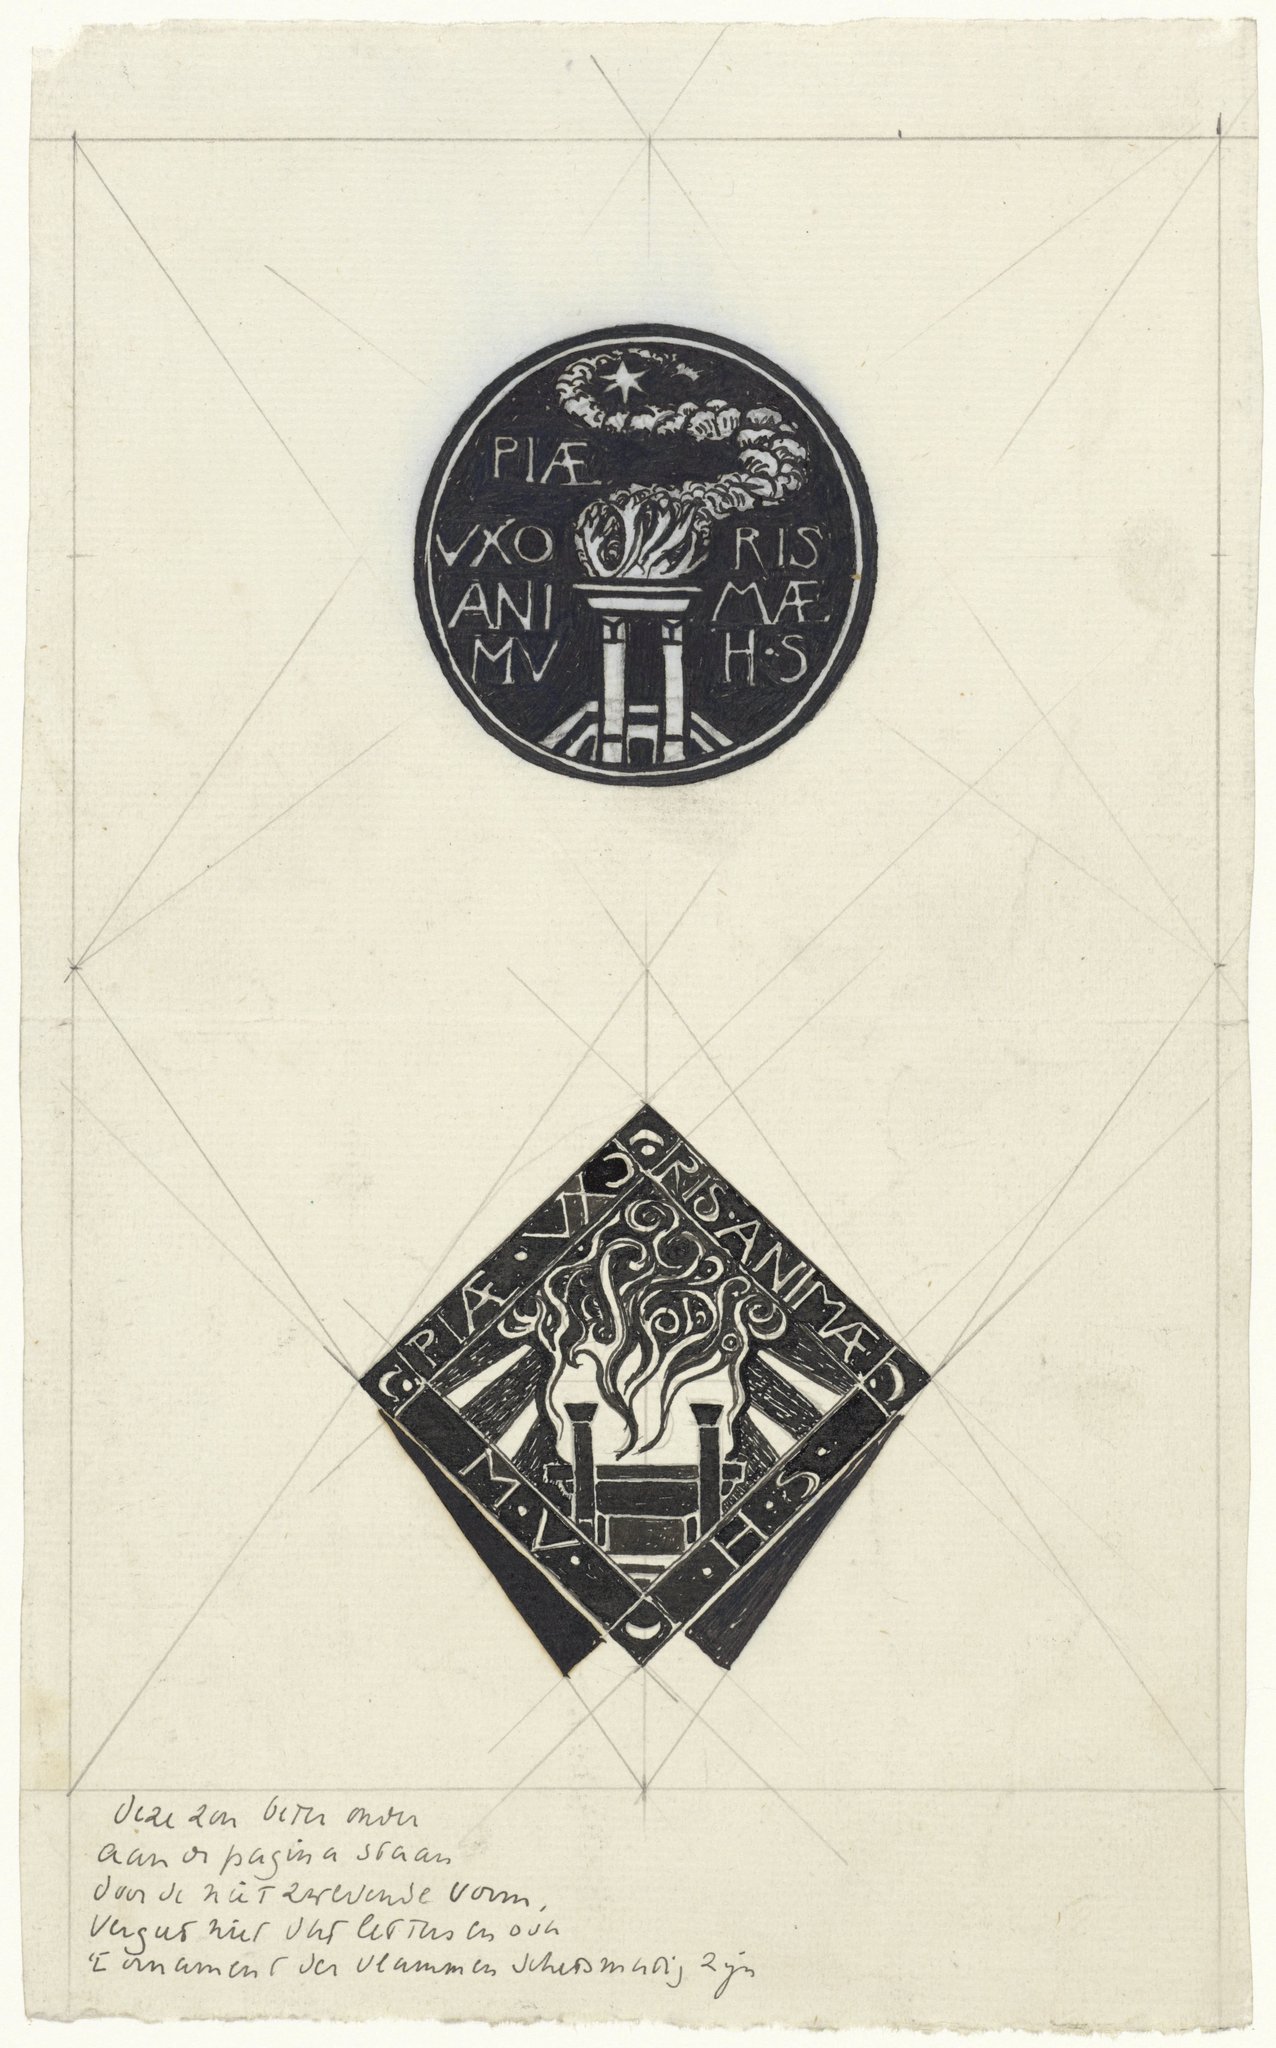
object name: design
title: Twee ontwerpen voor een vignet Piae Uxoris Animae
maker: richard nicolaüs roland holst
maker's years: 1868-1938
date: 1878-1938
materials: ink, paper, pencil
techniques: pen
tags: vignette